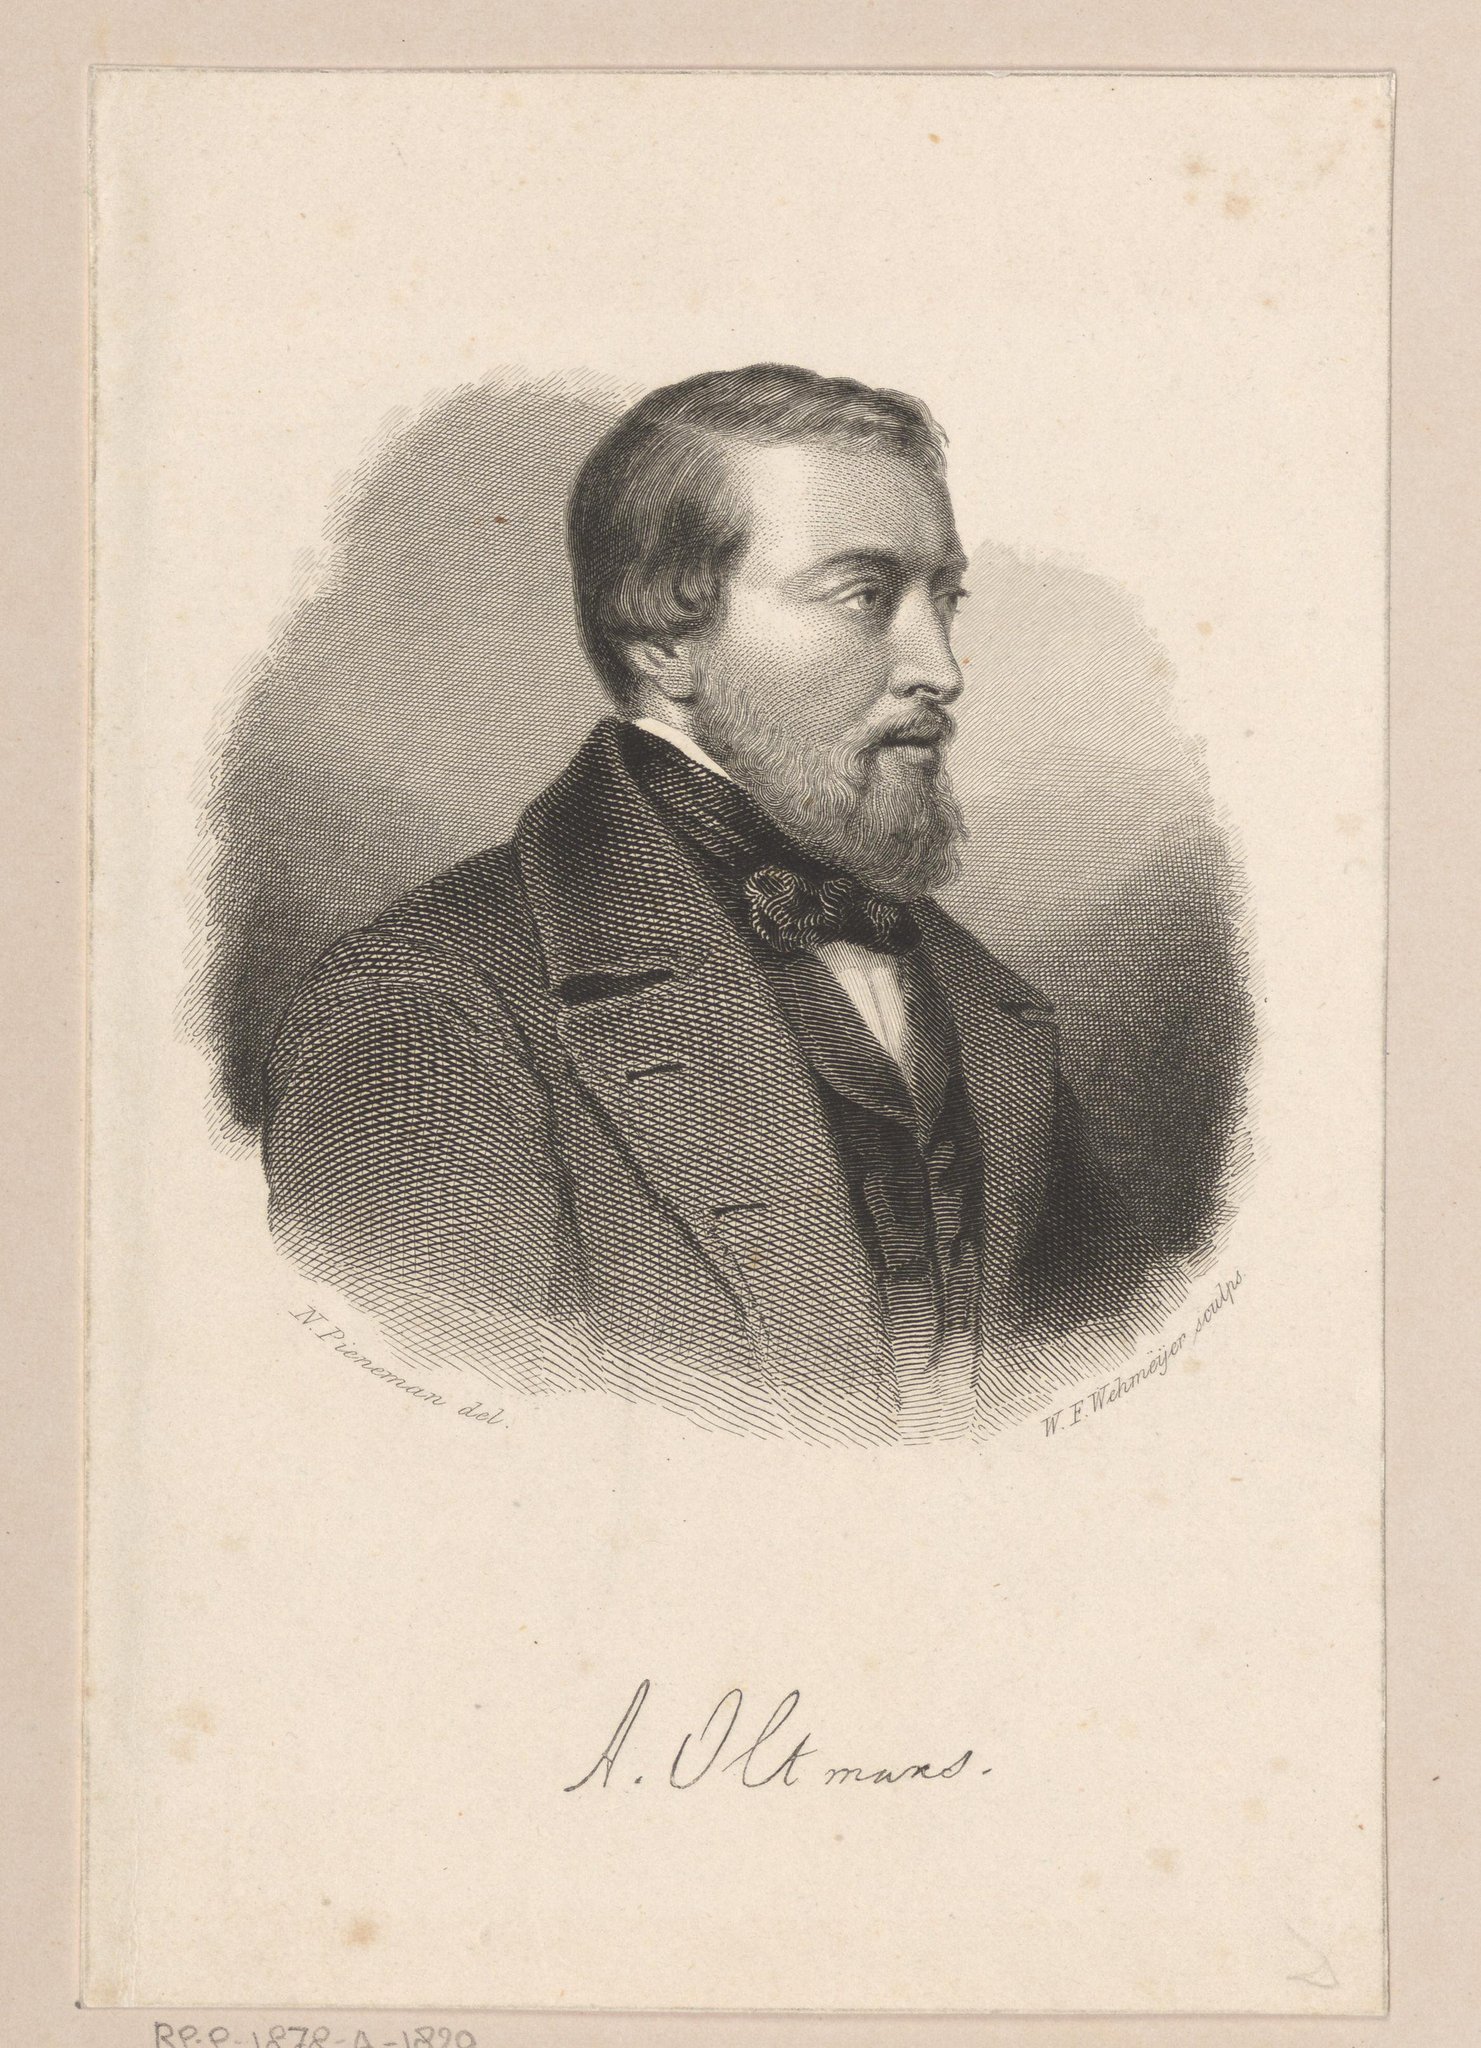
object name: print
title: Portret van Alexander Oltmans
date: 1829-1854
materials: paper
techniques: engraving, etching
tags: amsterdam, print maker, alexander oltmans, historical persons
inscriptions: collector's mark: Lugt 2228